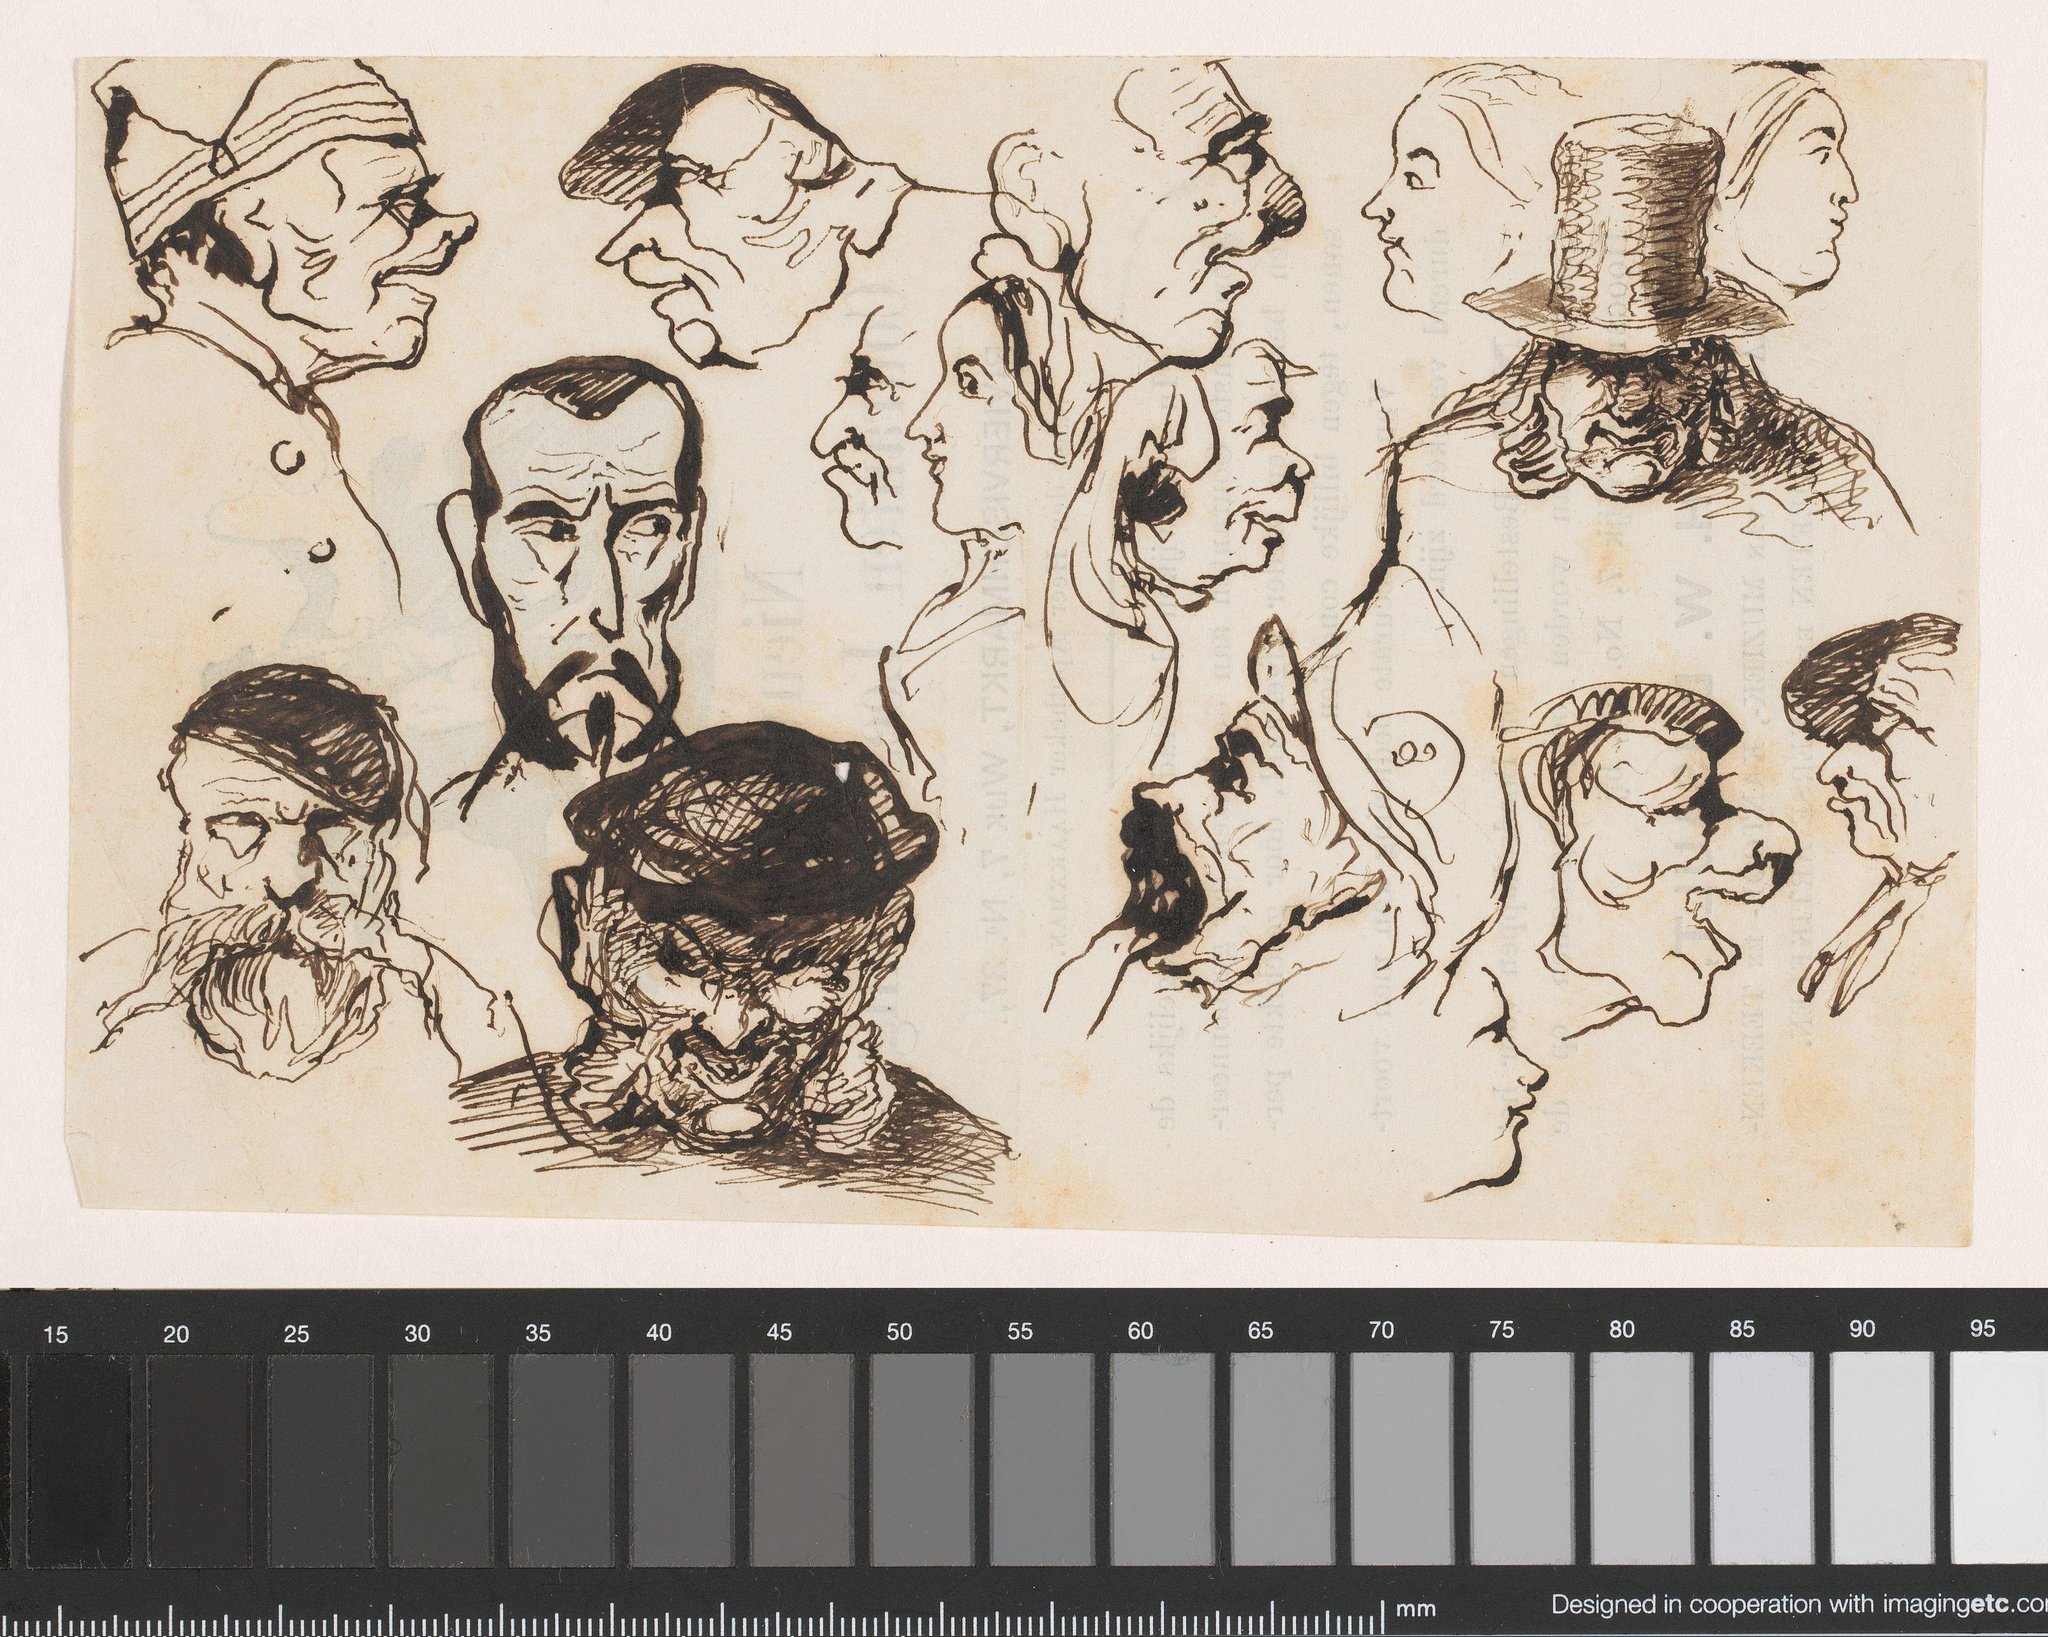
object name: drawing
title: Koppen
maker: johannes tavenraat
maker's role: draughtsman, painter, print maker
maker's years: 1809-1881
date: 1840-1880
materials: ink, paper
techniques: brush, pen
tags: caricatures (human types)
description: Schetsblad met karikaturale koppen. Getekend op de achterzijde van een reclamedrukwerk van de 'Nieuwe Couranten Leesinrigting'.